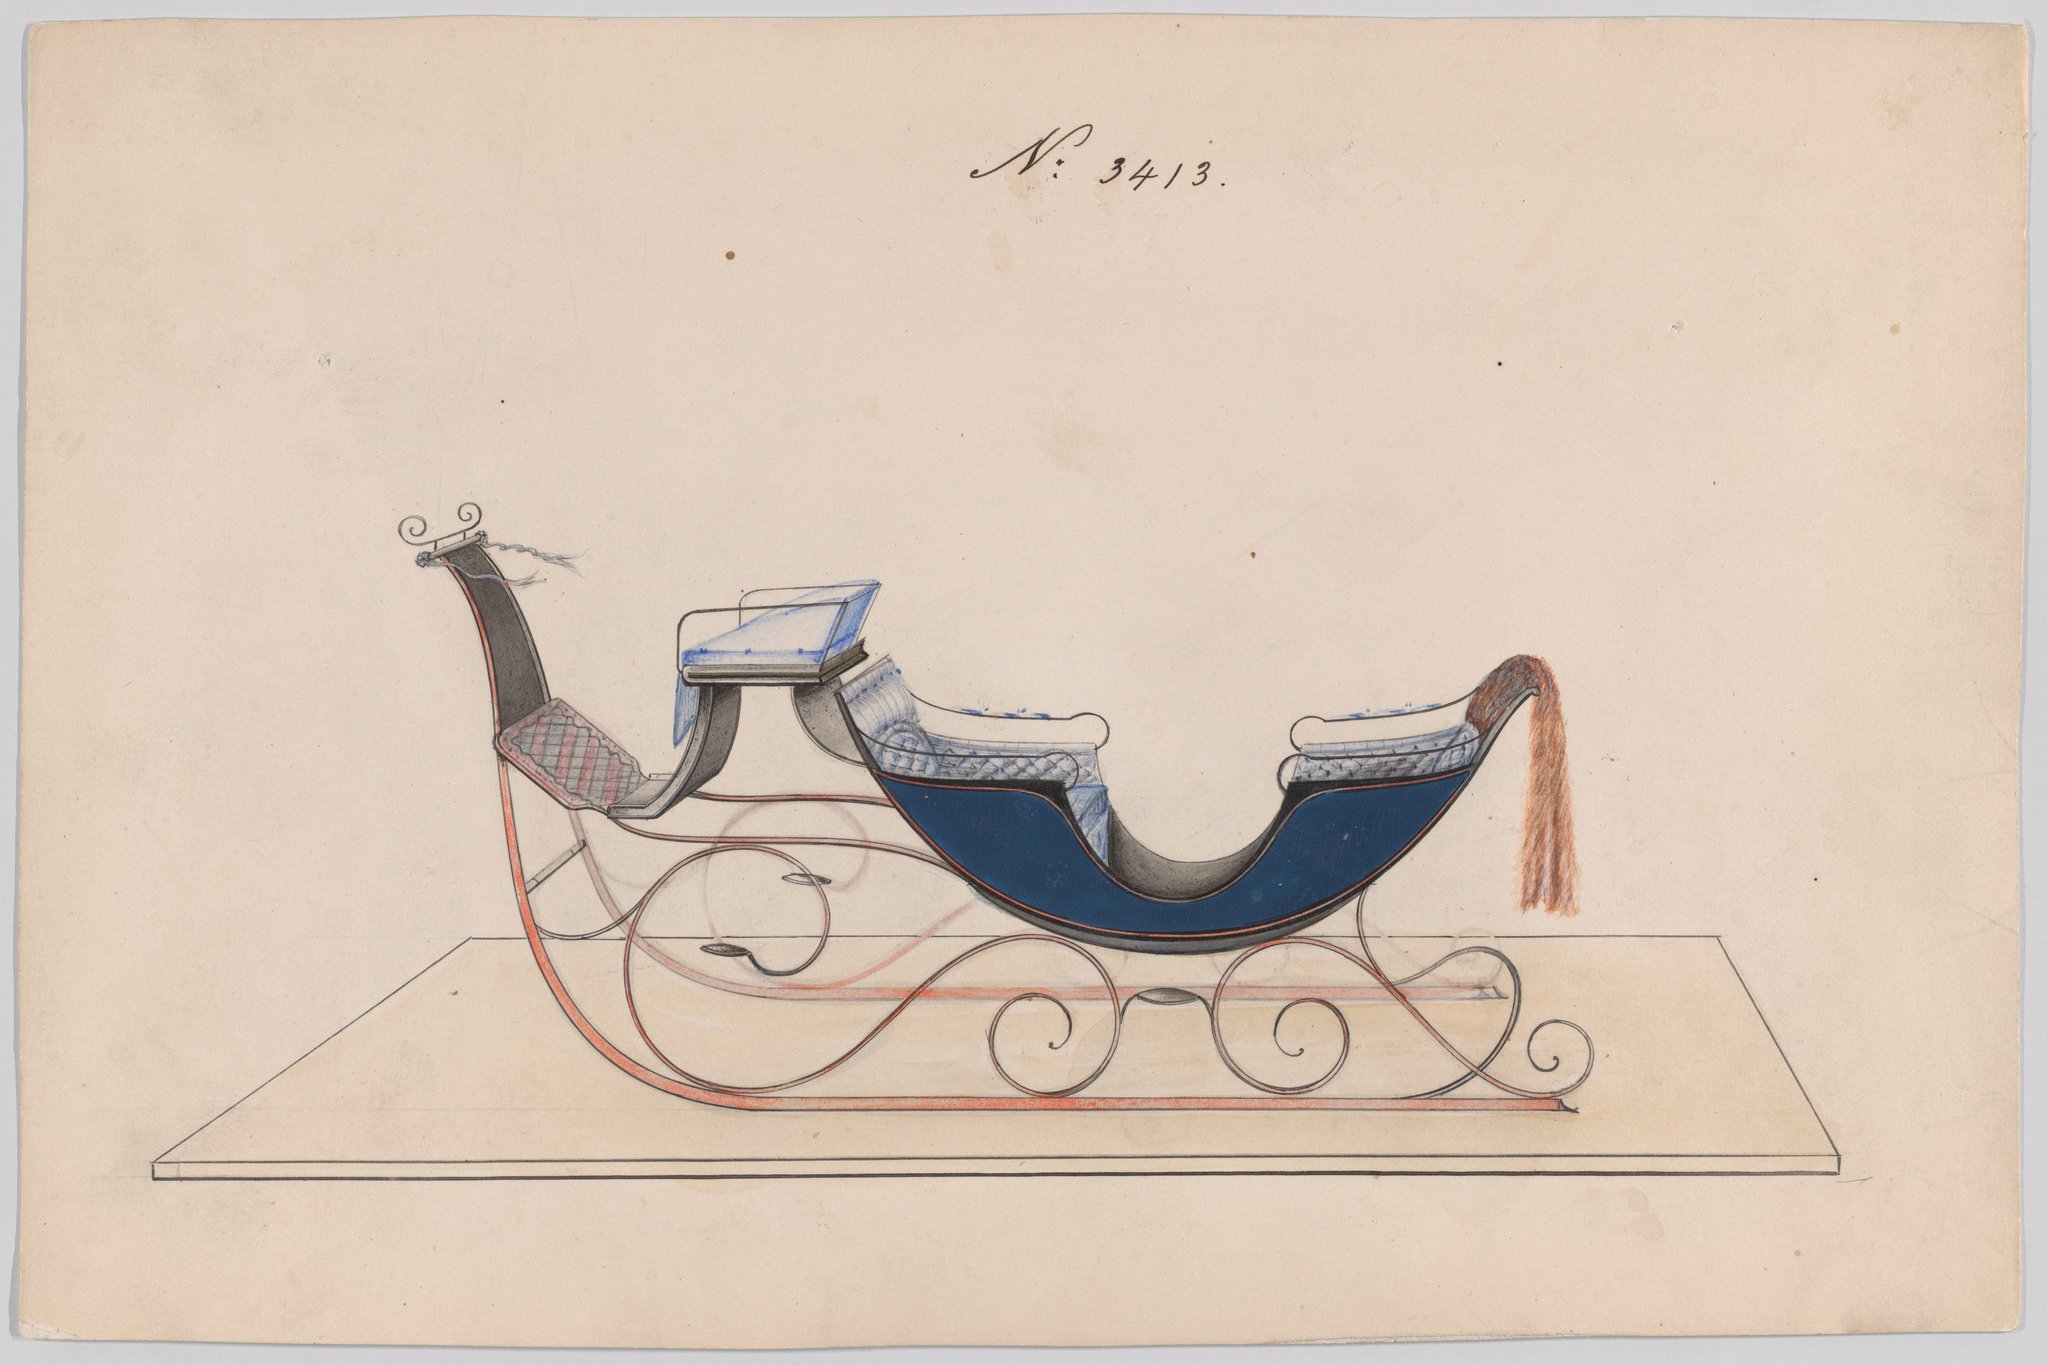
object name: drawing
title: Sleigh, no. 3413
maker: brewster & co.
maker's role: manufacturer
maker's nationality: american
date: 1878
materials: gouache, gum arabic, ink, watercolor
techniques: pen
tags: sleighs